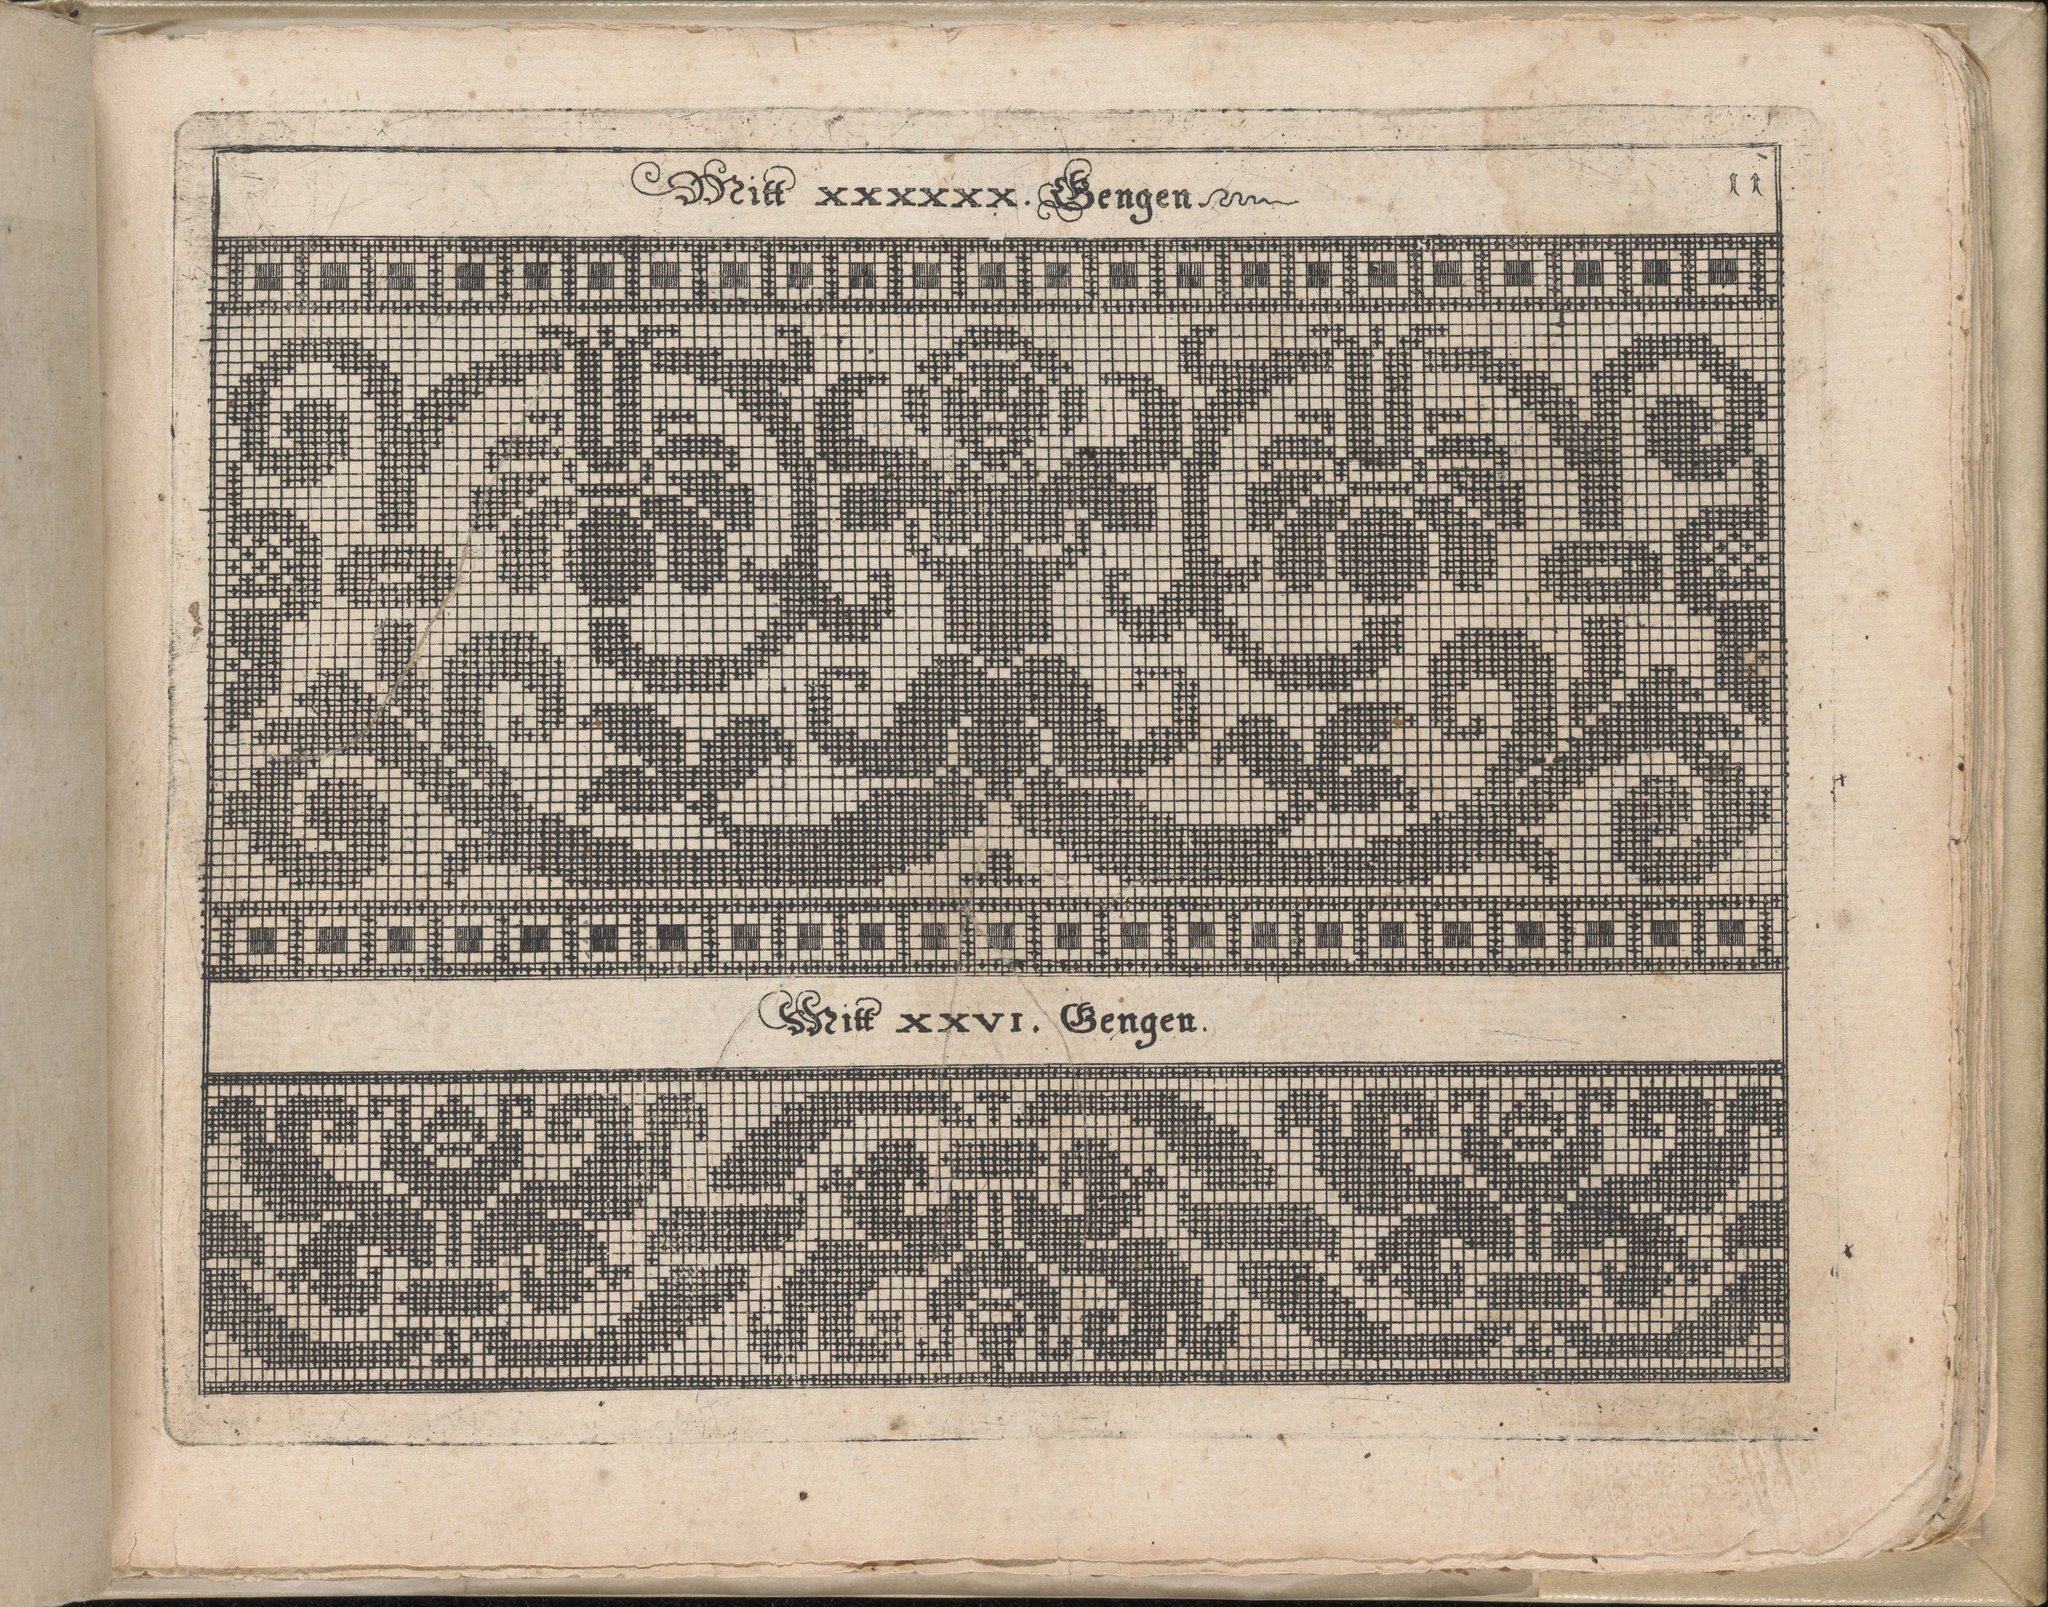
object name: book print ornament architecture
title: Schön Neues Modelbuch (Page 16 recto)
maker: johann sibmacher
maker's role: designer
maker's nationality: german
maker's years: 1590-1611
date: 1597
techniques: etching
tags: ornament